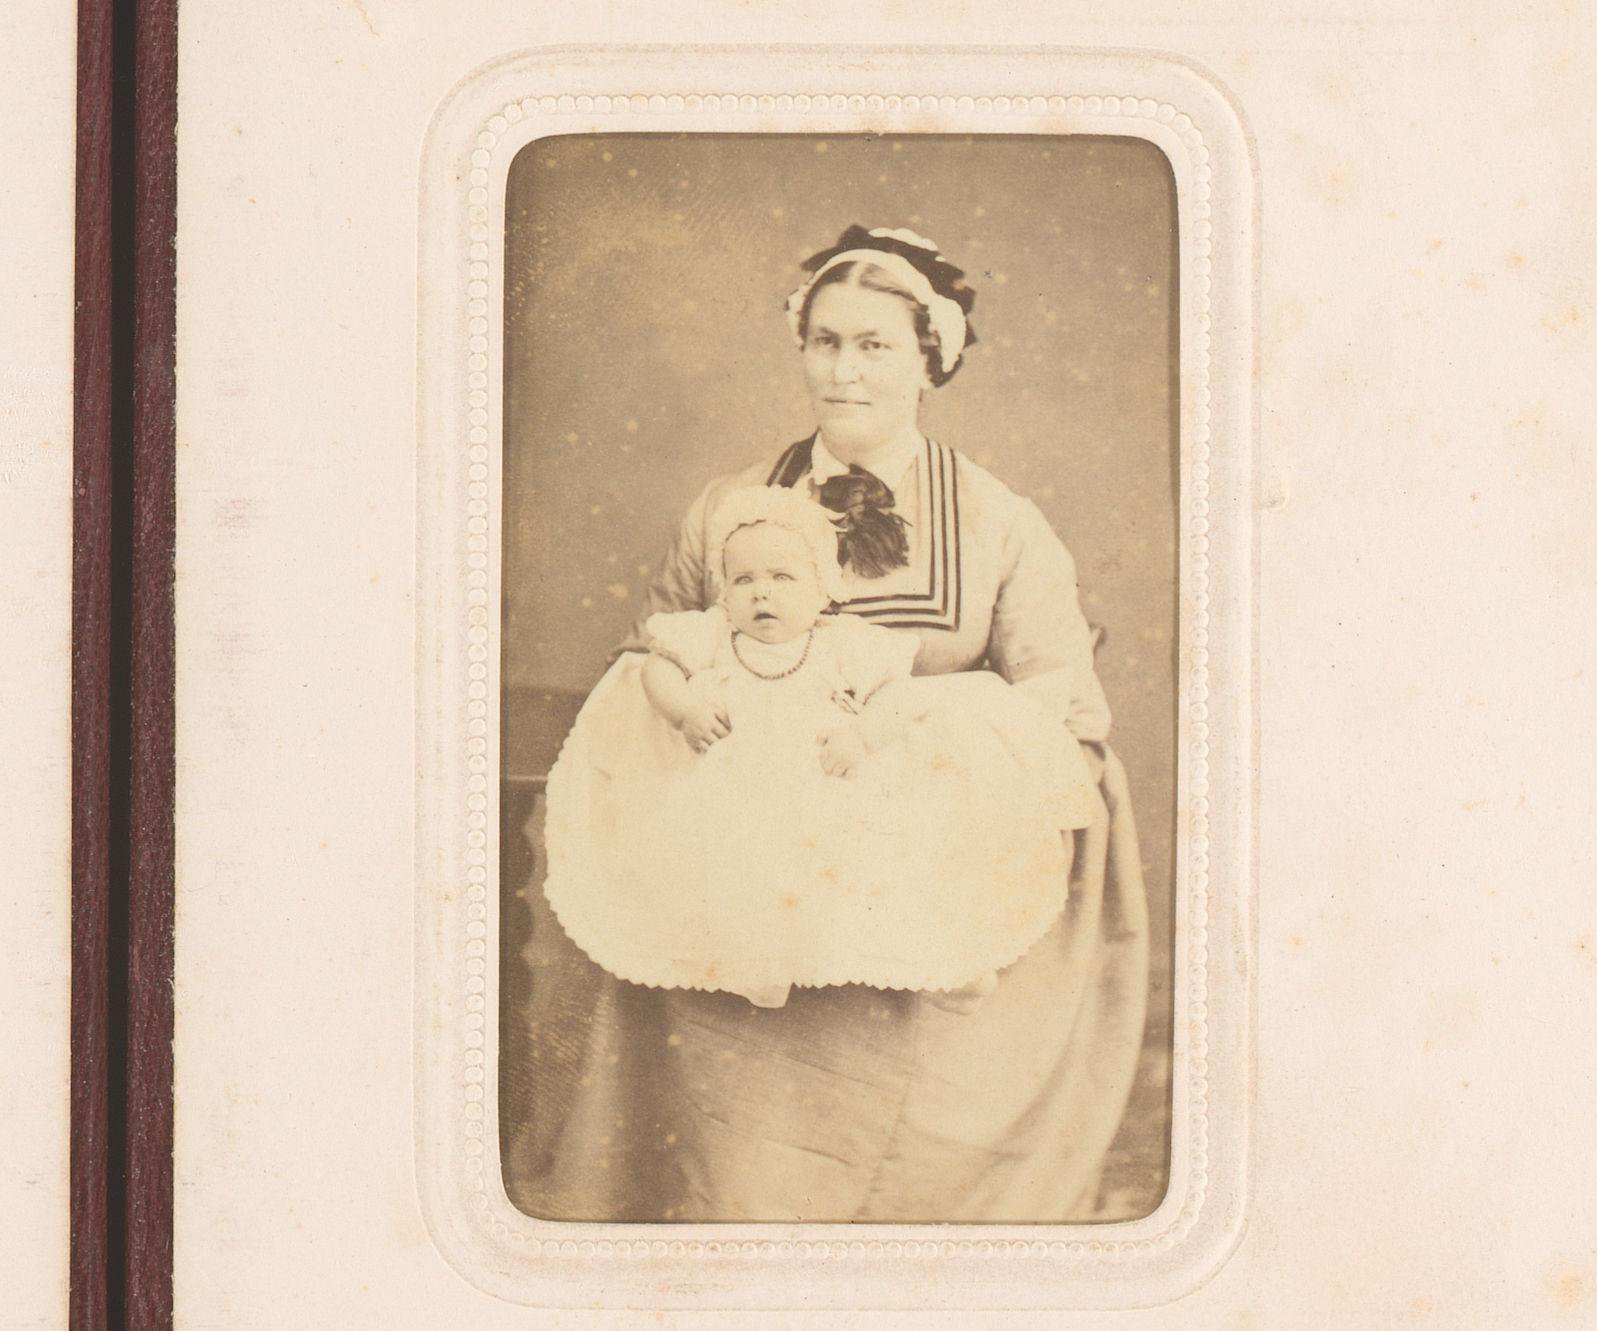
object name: album leaf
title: Portret van een zittende vrouw met een baby in witte jurk op schoot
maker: stanislas victor bureau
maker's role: fotograaf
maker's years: 1810-1888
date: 1805-1873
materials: cardboard, photographic support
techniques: albumen print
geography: paris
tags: sitting figure - aa - female human figure, historical persons - bb - woman, infant, baby ~ the ages of man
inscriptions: annotation: ‘Mei 1873./ J. A. vd [h].’, inscription: ‘S. BUREAU/ 44, Palais Royal/ 28, Rue Montpensier/ PARIS/ Tous les Clichés sont conservés.’